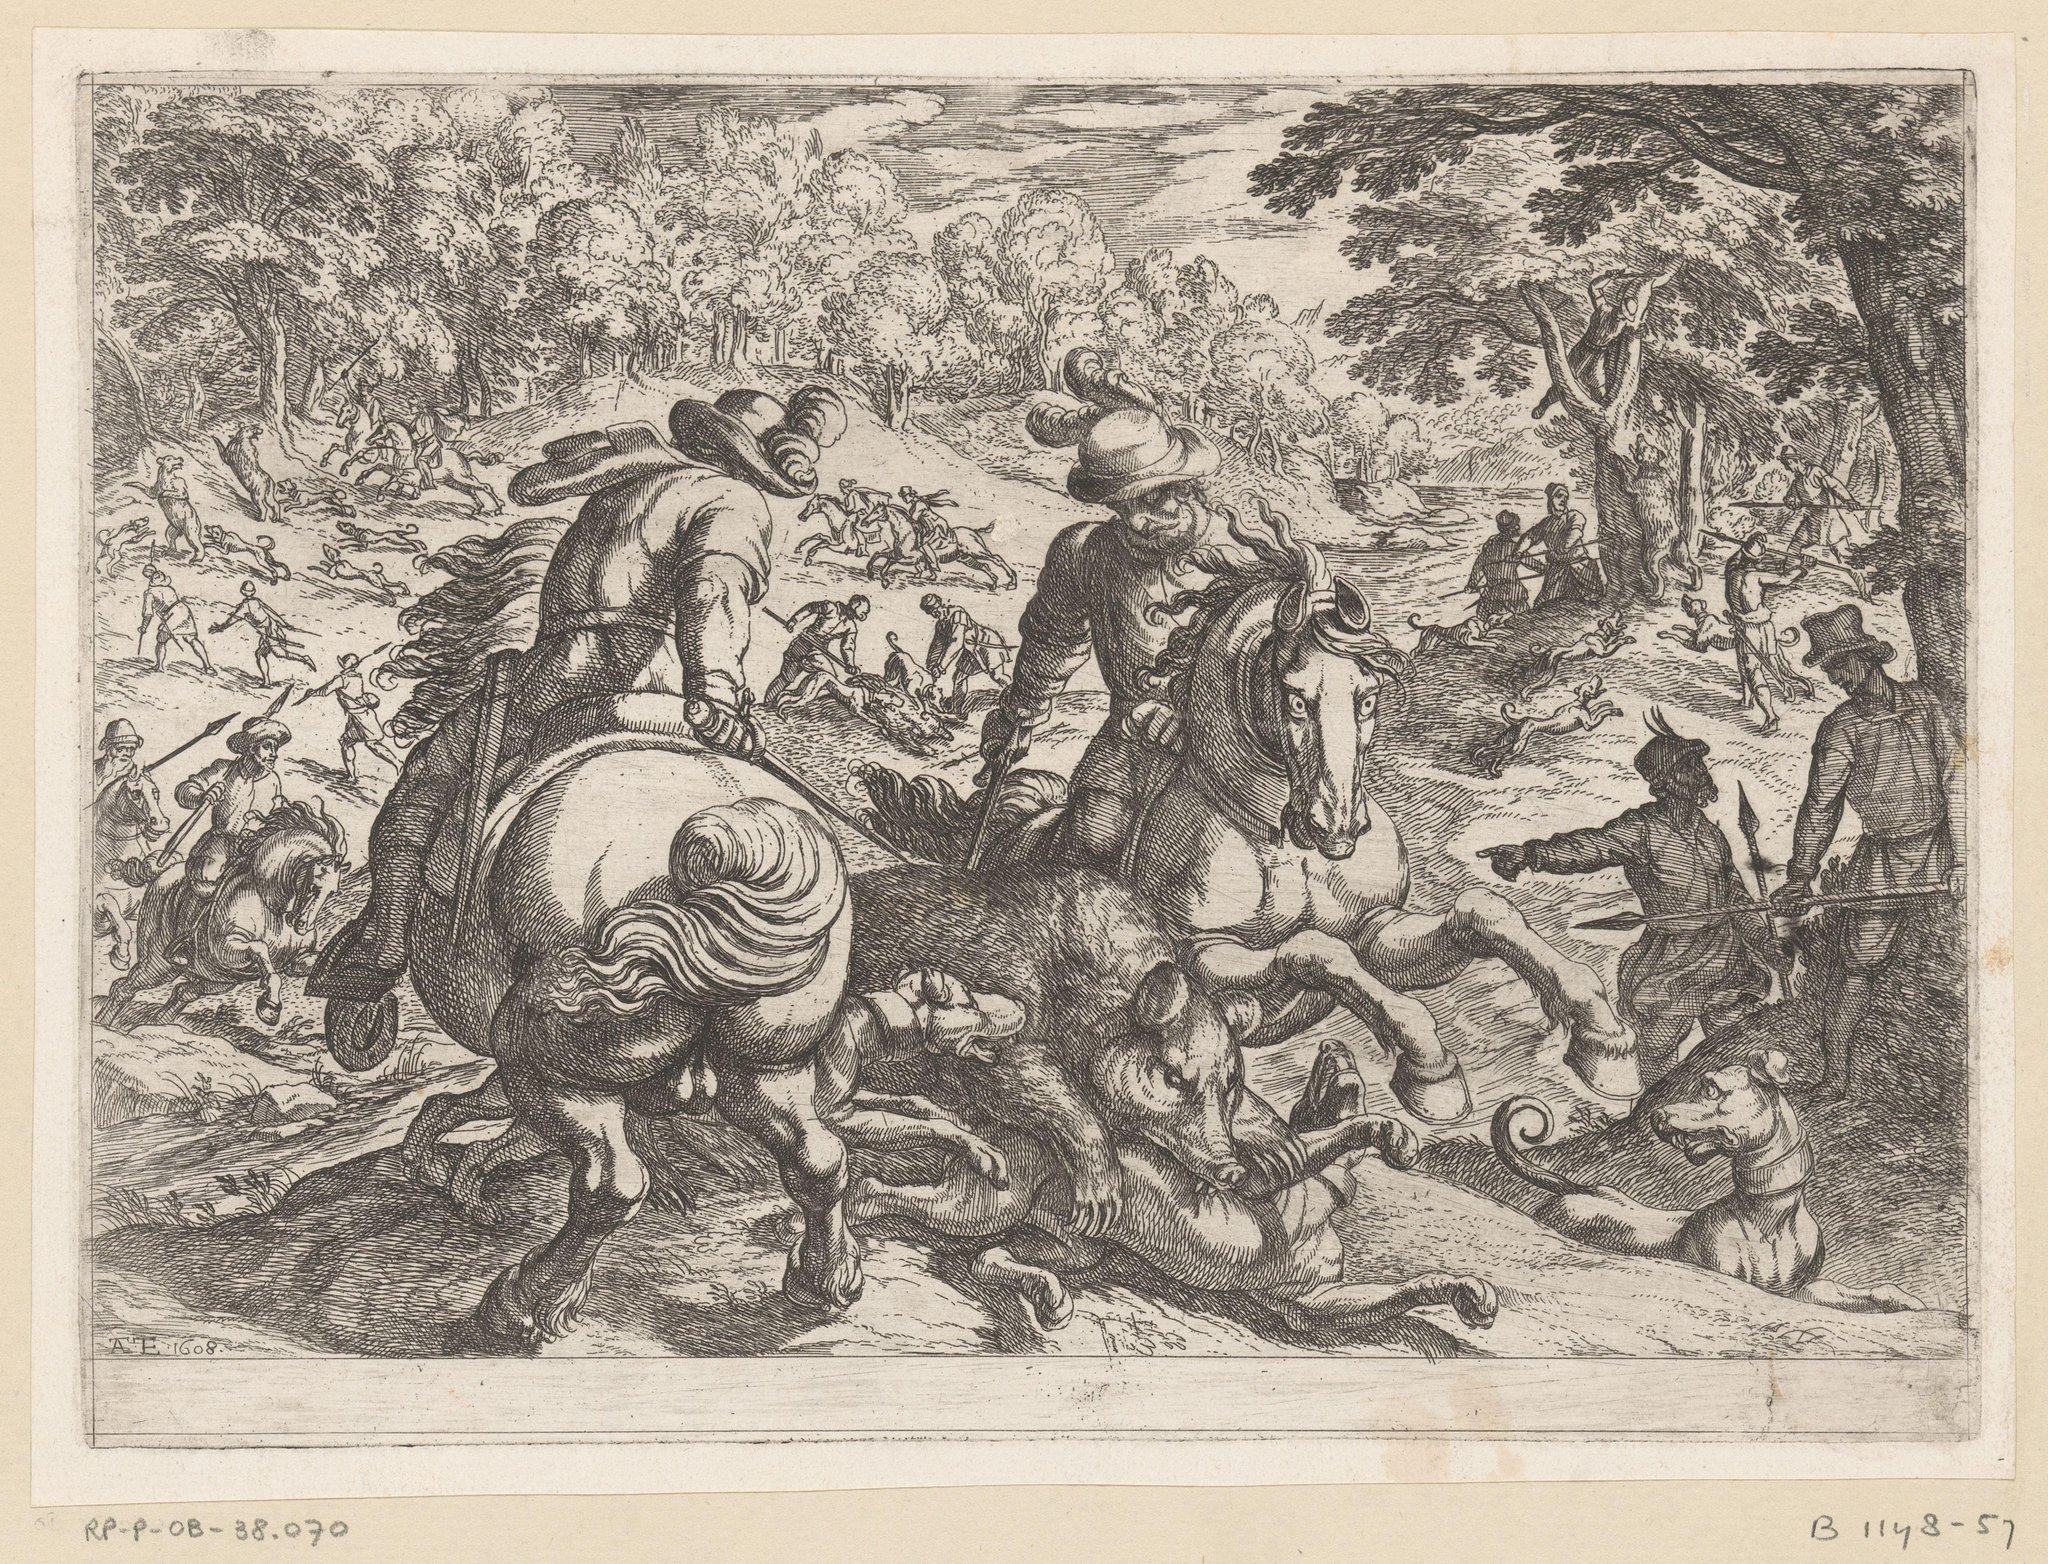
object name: print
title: Jacht op beren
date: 1608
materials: paper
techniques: etching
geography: rome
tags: hunter, hunters hunting (n.b.: in 1988-1990 this notation denoted the concept of 43c11421 'hunters resting during the hunt'), beasts of prey, predatory animals: bear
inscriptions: collector's mark: Lugt 240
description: Landschap met jagers te paard jagend op beren. Op de voorgrond een beer die een jachthond grijpt.